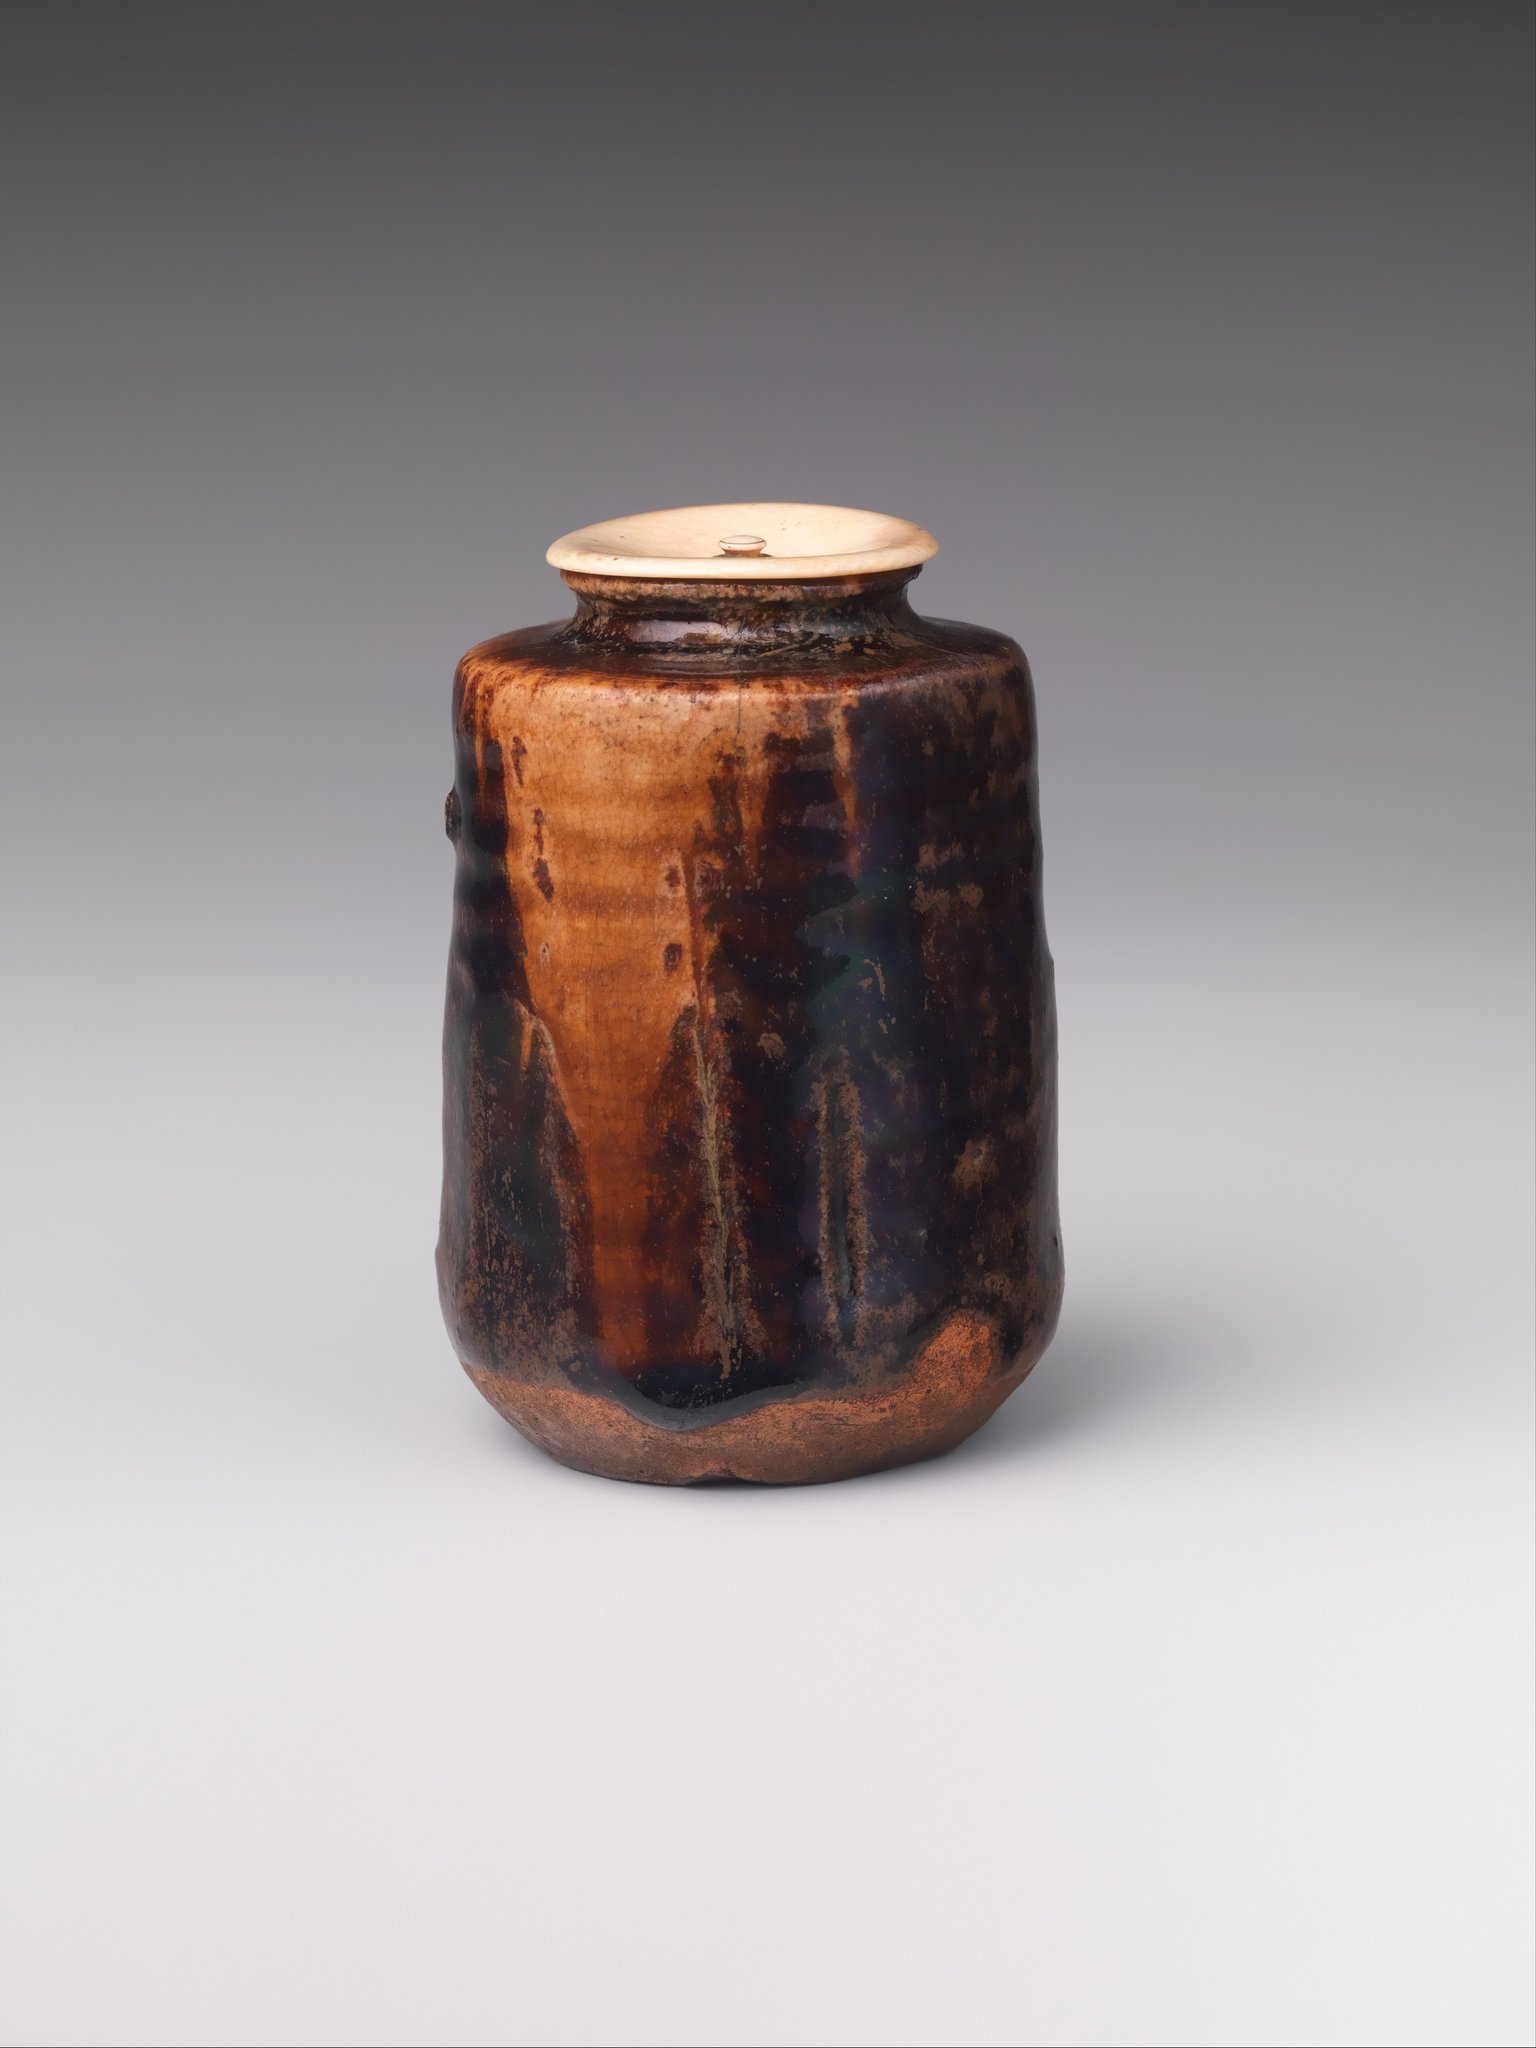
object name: tea caddy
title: Tea Caddy (Chaire)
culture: japanese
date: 1567-1600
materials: wood, glaze, stoneware